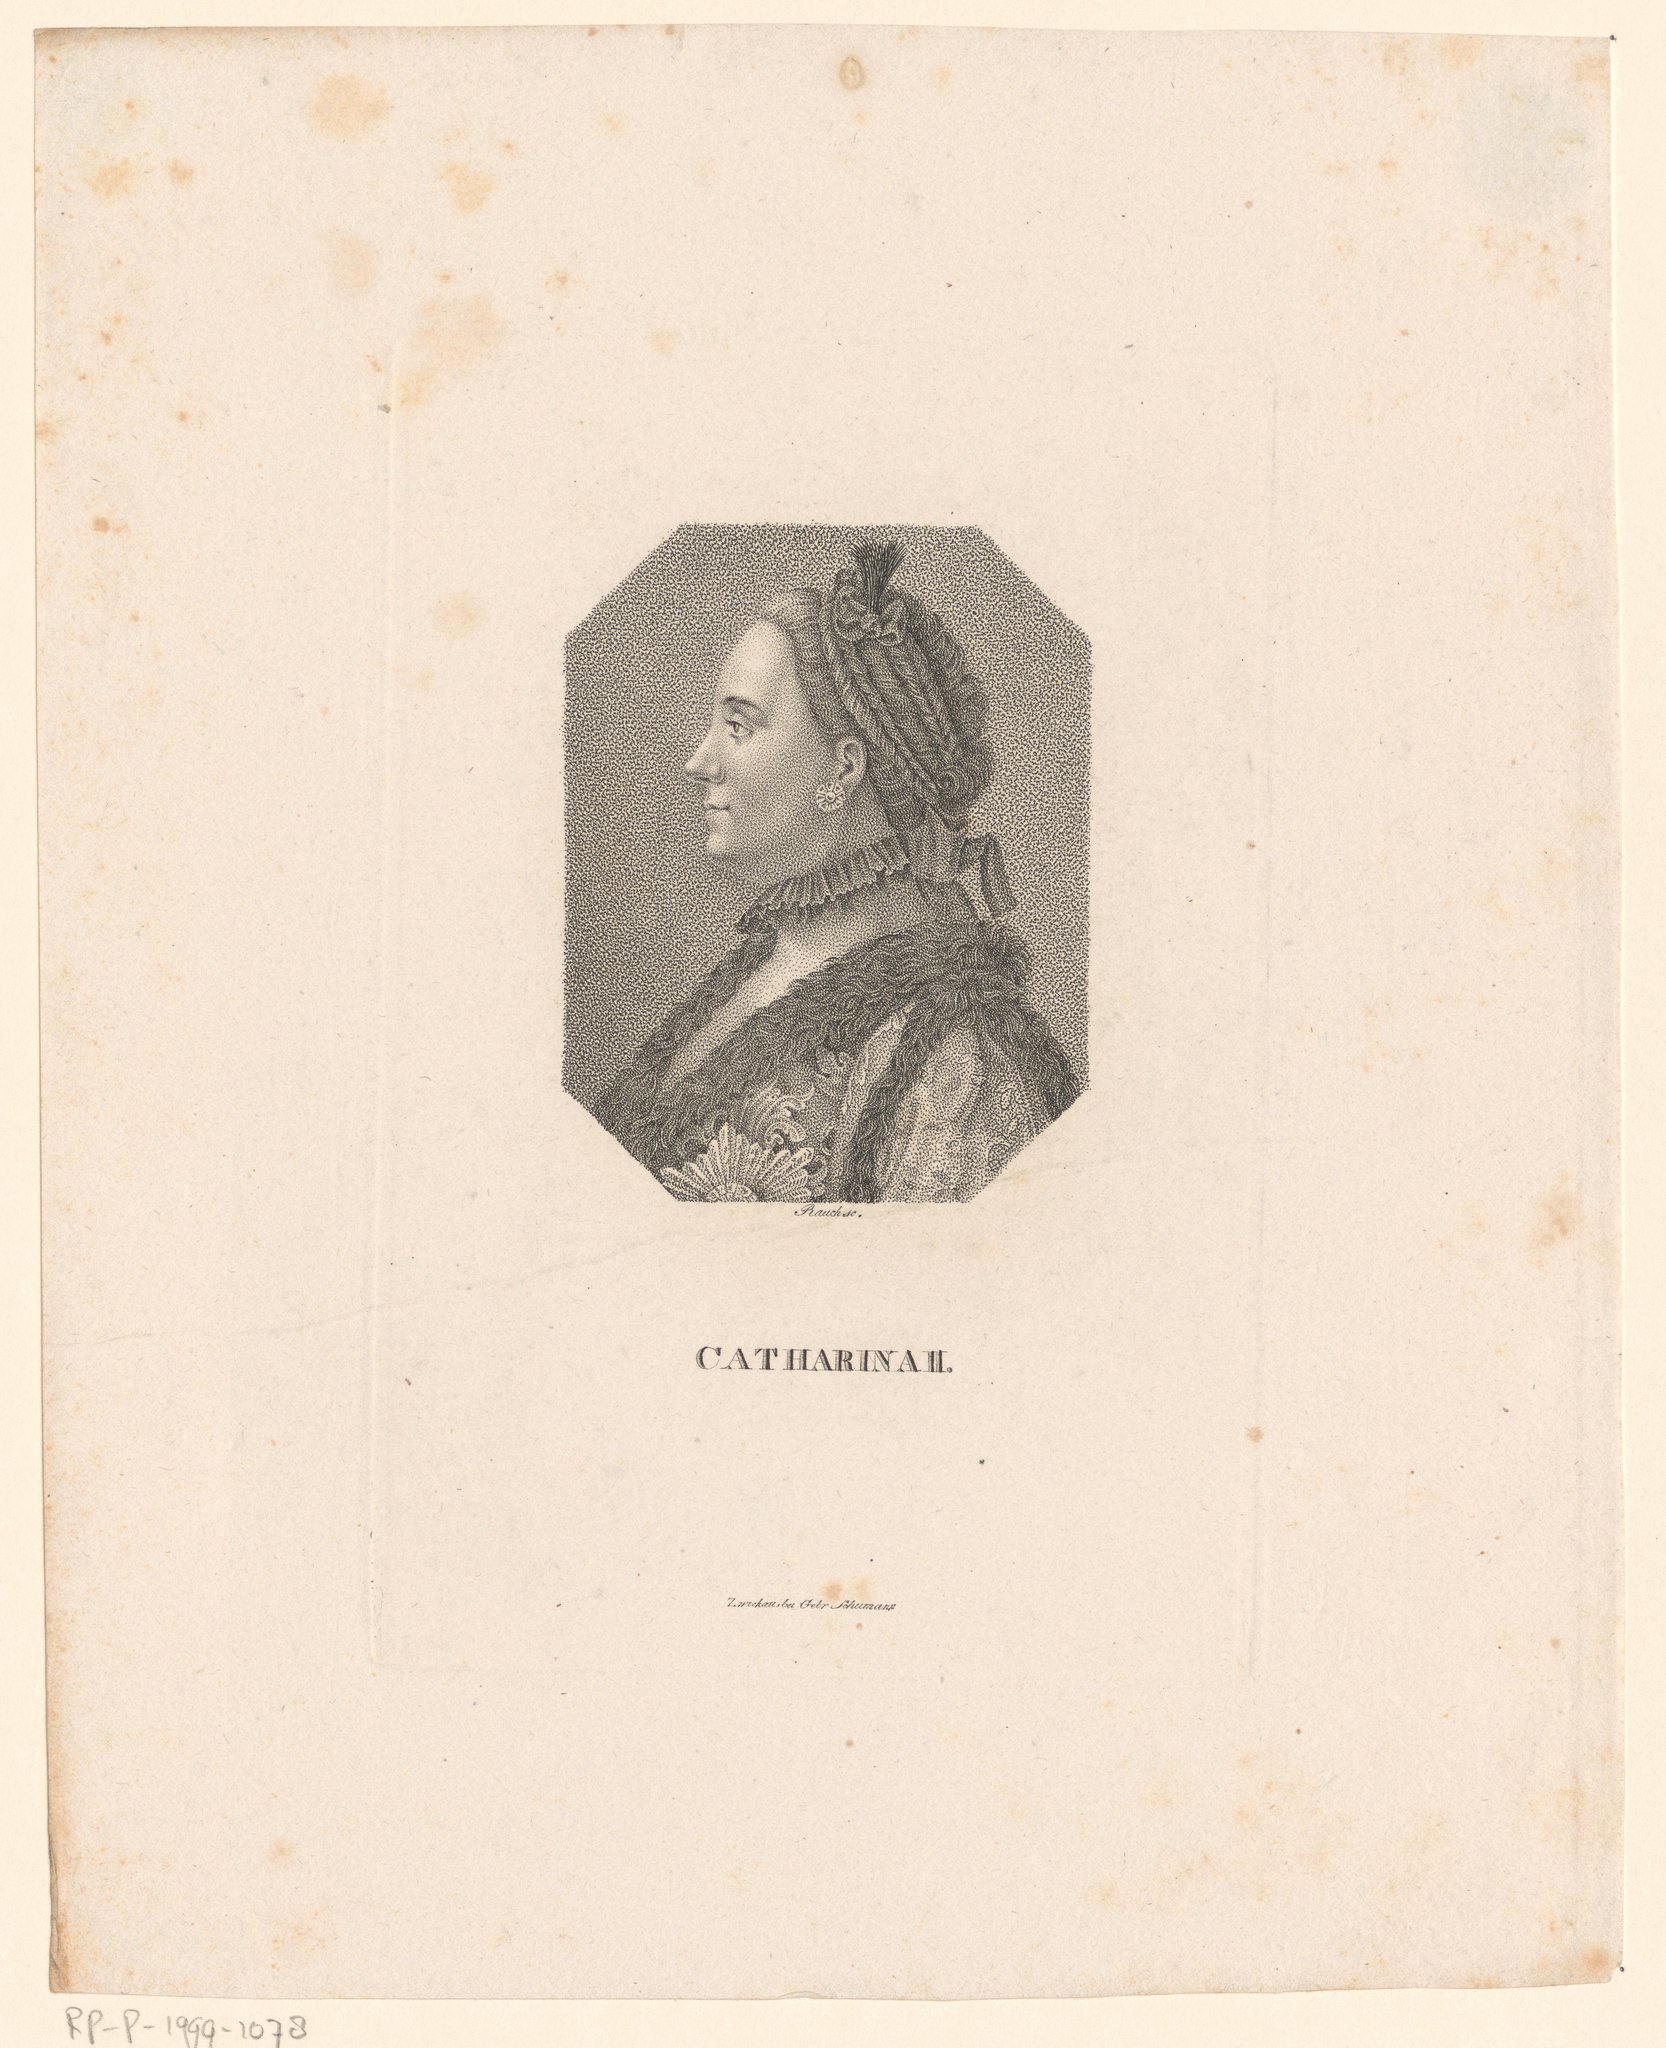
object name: print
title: Portret van Catharina de Grote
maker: ernst rauch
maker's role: print maker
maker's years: 1797-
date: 1807-1843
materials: paper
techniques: engraving, etching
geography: zwickau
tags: catharina de grote, historical persons - bb - woman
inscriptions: collector's mark: Lugt 2760, collector's mark: Lugt 2228